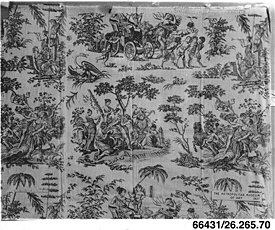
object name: piece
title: Europa and the Bull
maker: petitpierre et cie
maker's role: manufactory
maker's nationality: french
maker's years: 1790-1802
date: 1800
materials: cotton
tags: human figures,europa,bulls,trees